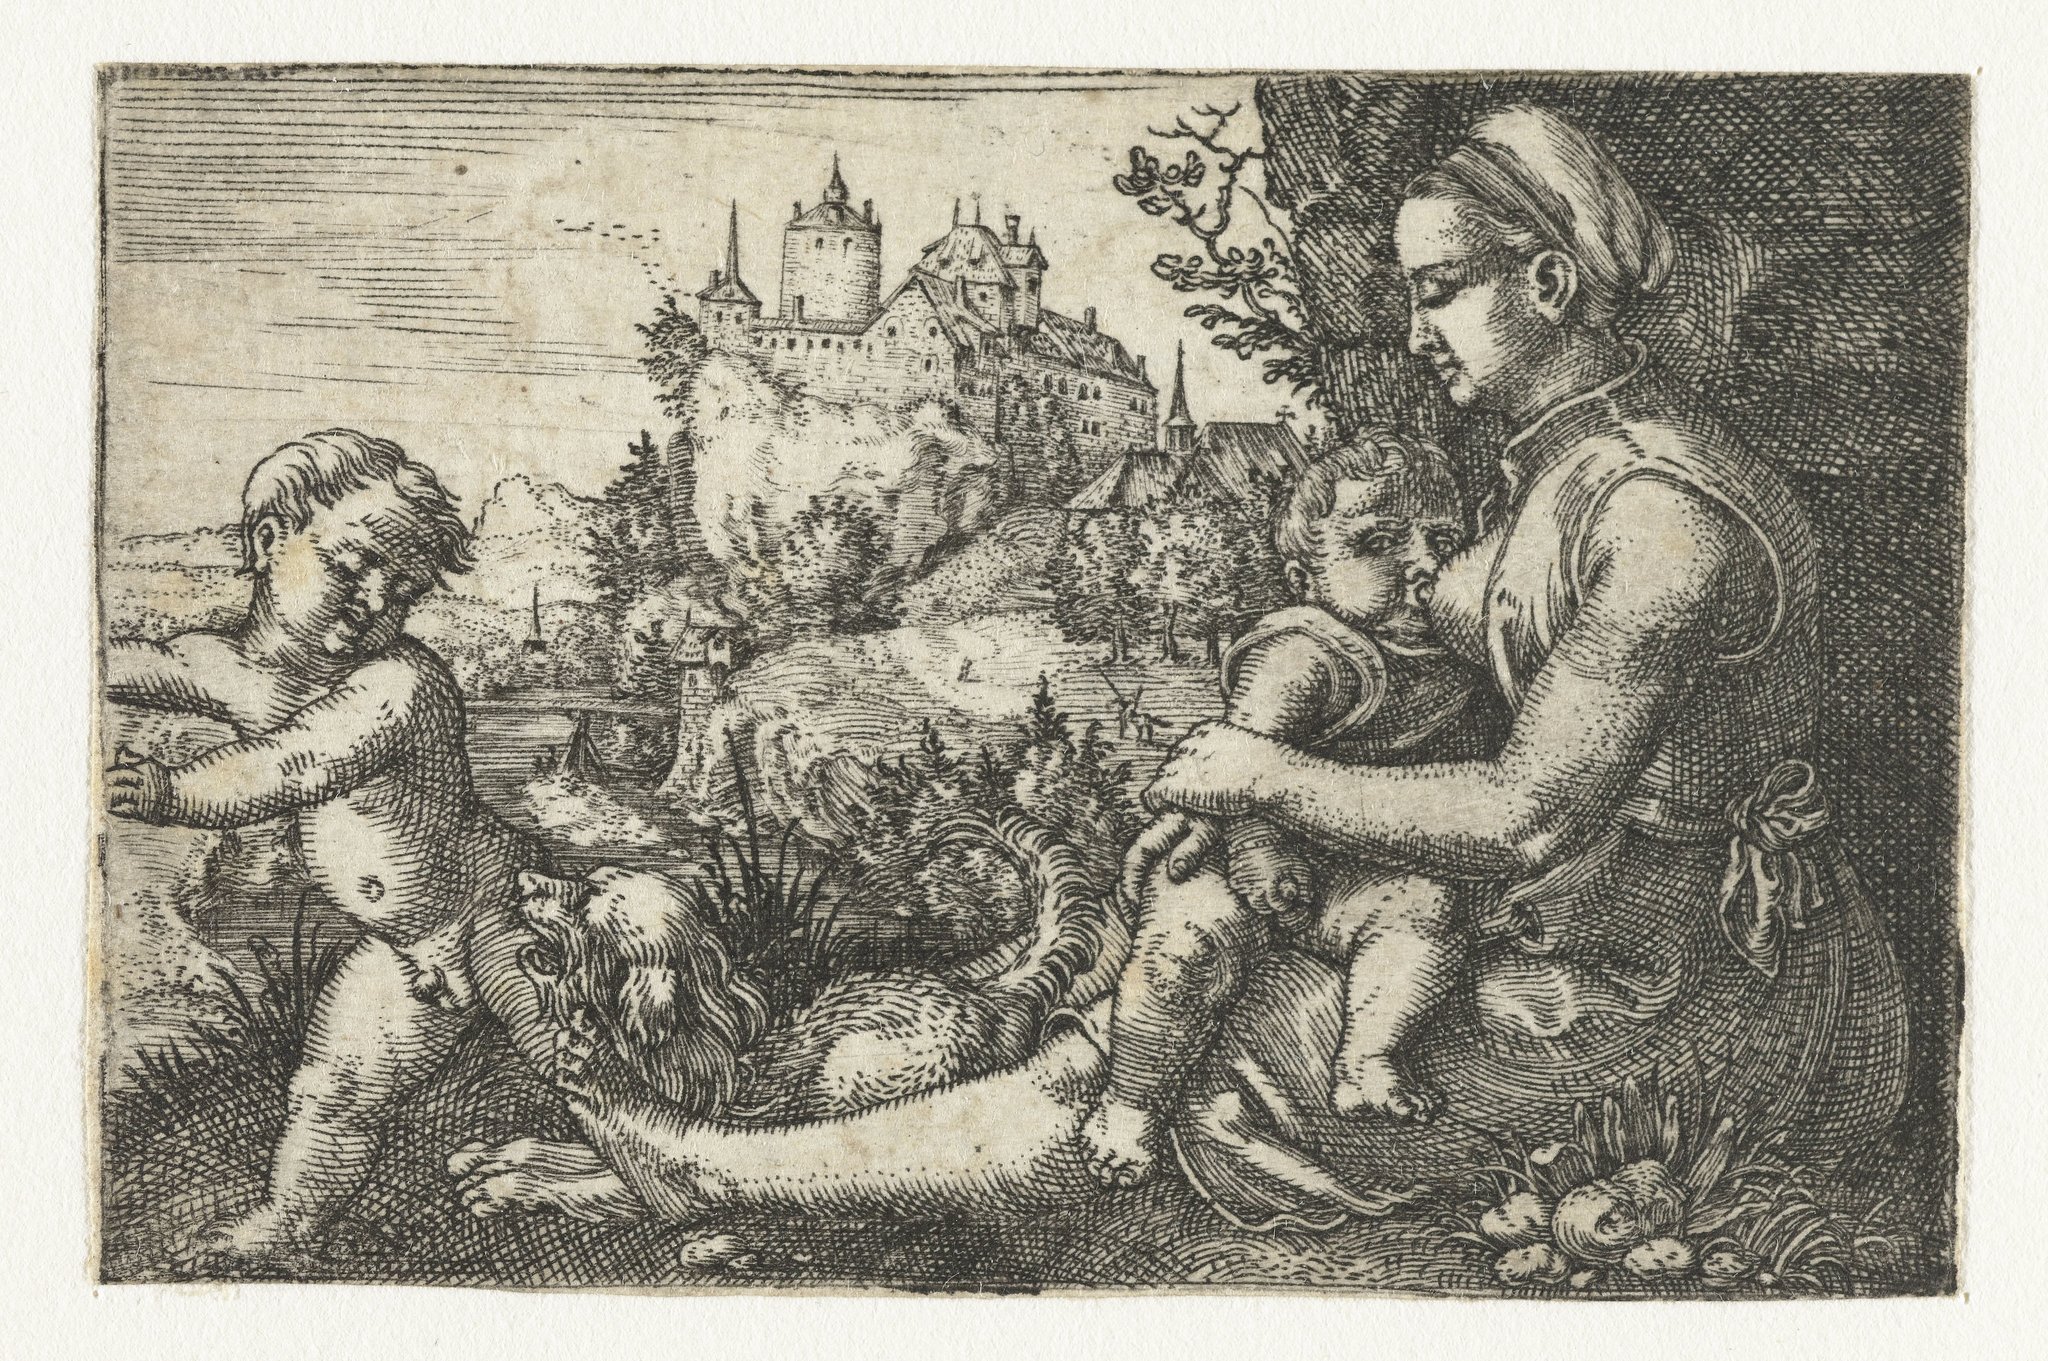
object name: print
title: Moeder met twee kinderen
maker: barthel beham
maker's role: print maker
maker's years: 1502-1540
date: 1512-1540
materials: paper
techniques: engraving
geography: germany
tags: mother and baby or young child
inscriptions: collector's mark: Lugt 212, collector's mark: Lugt 2228a